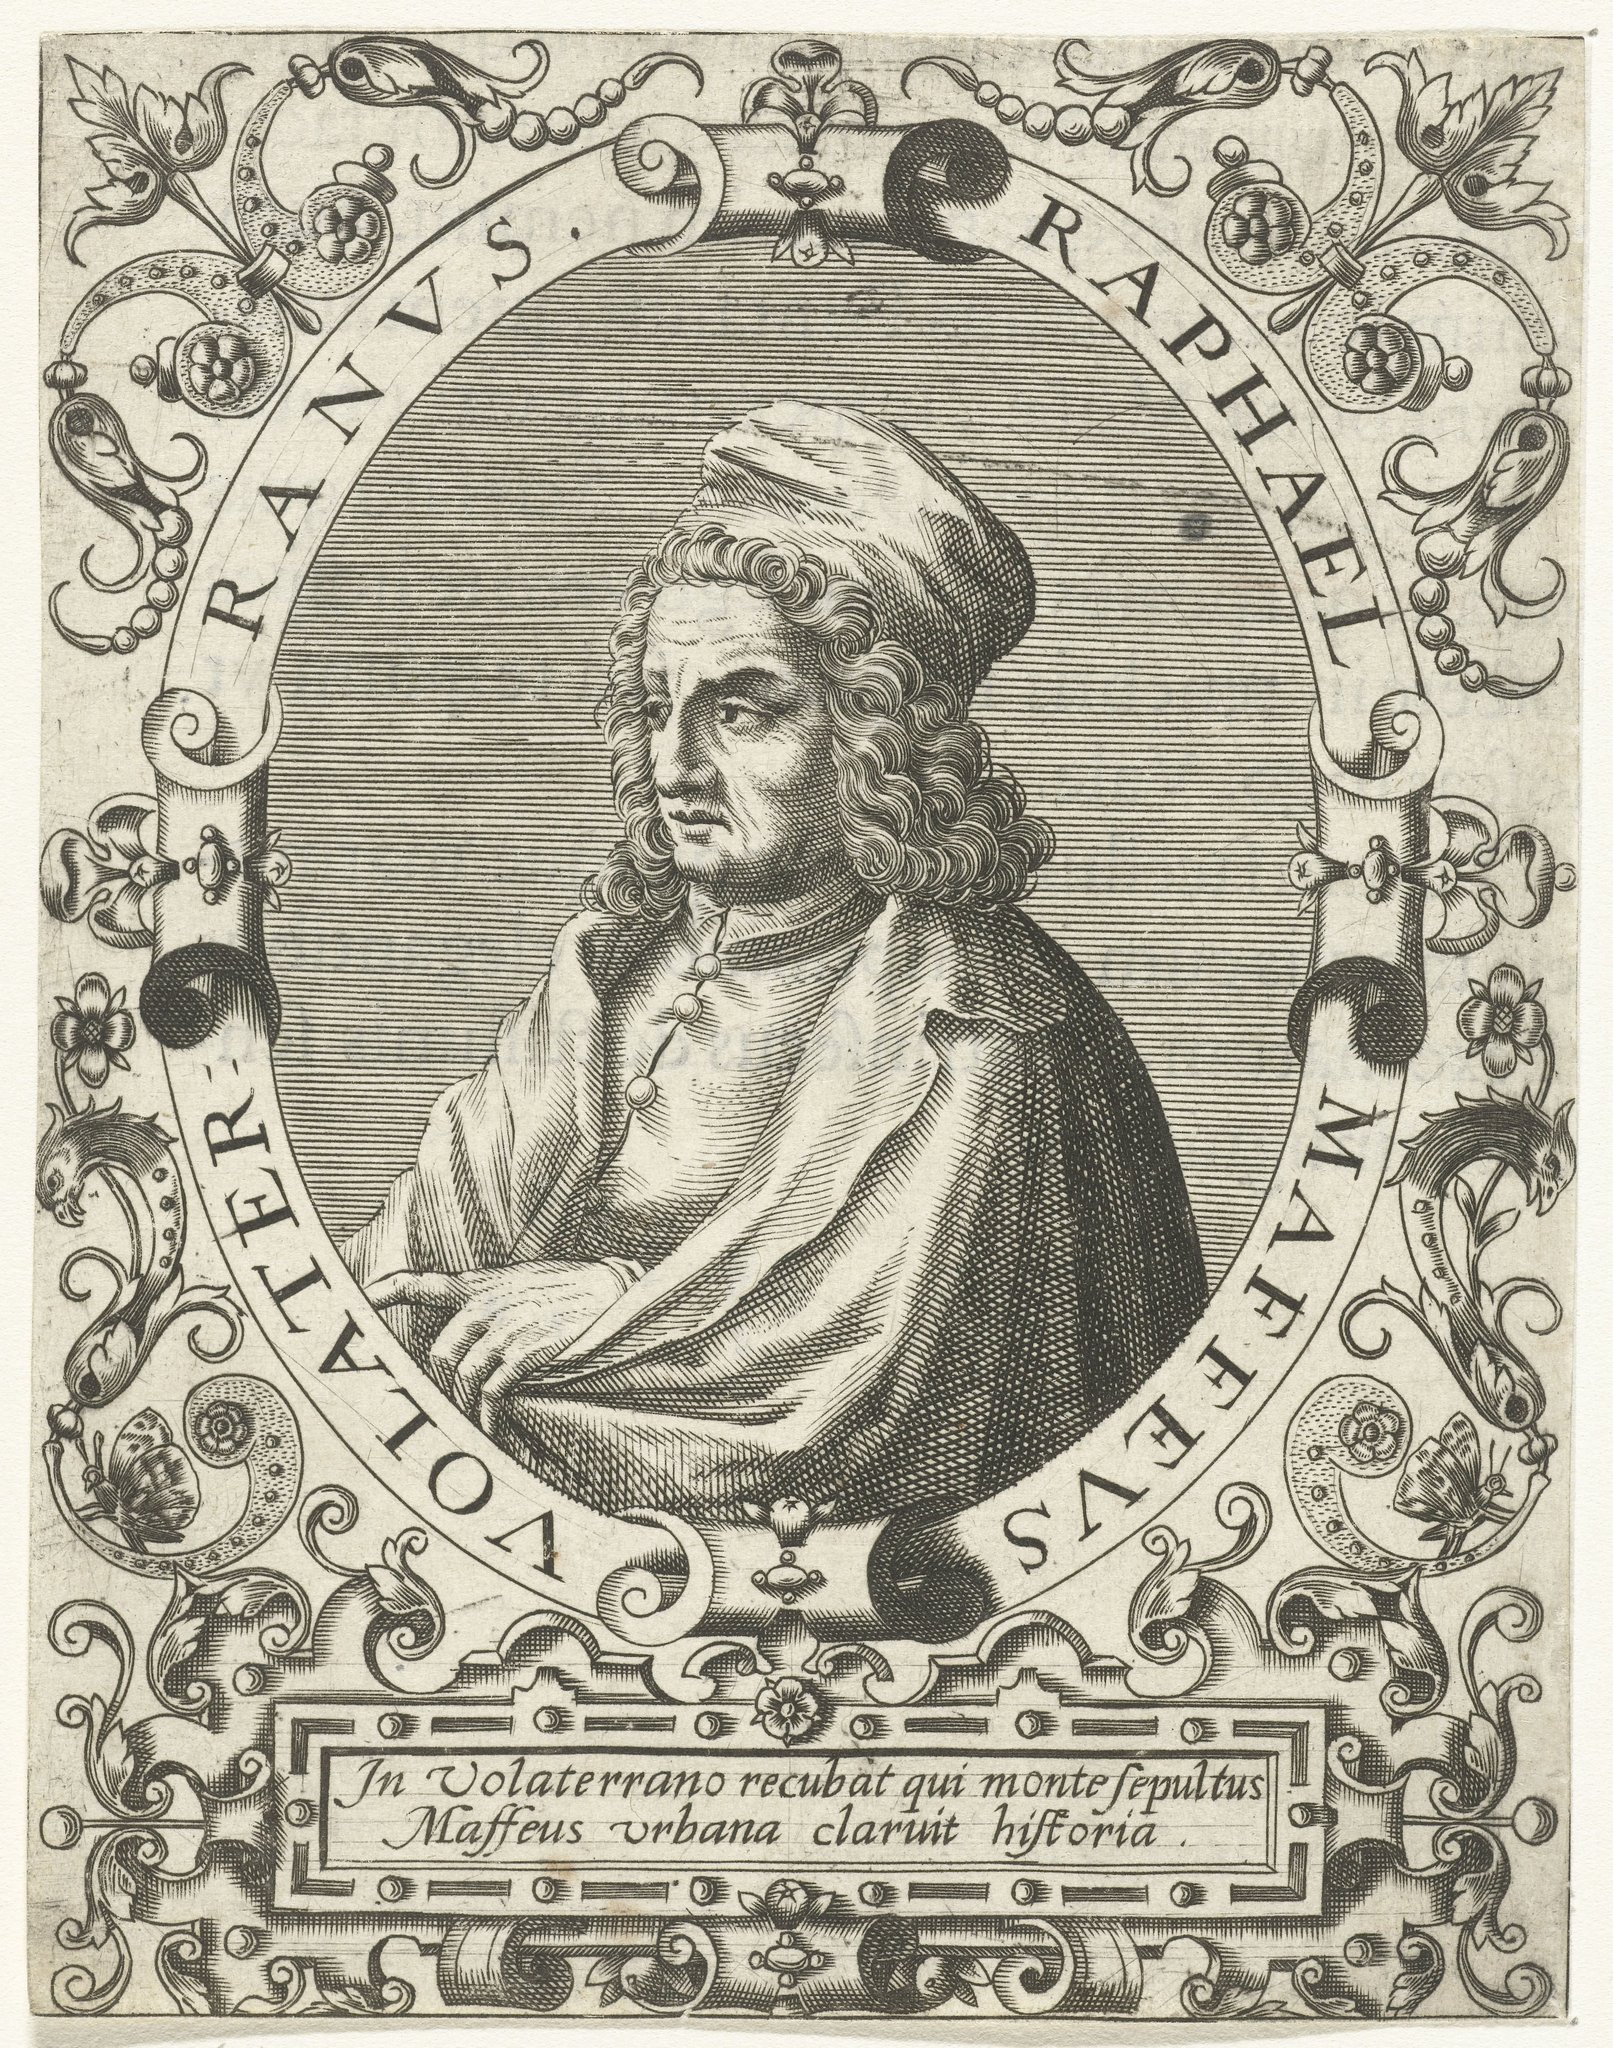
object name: print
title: Portret van Raffaele Maffei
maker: jean jacques boissard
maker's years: 1528-1598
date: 1597-1599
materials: paper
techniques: engraving, letterpress printing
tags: volterra, humanist, geleerde, raffaello maffei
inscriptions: collector's mark: Lugt 2228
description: Gemaakt voor: J.J. Boissard, Icones virorum illustrium doctrina &c eruditione praestanti um contines. Frankfurt am Main: de Bry, 1597-1599.